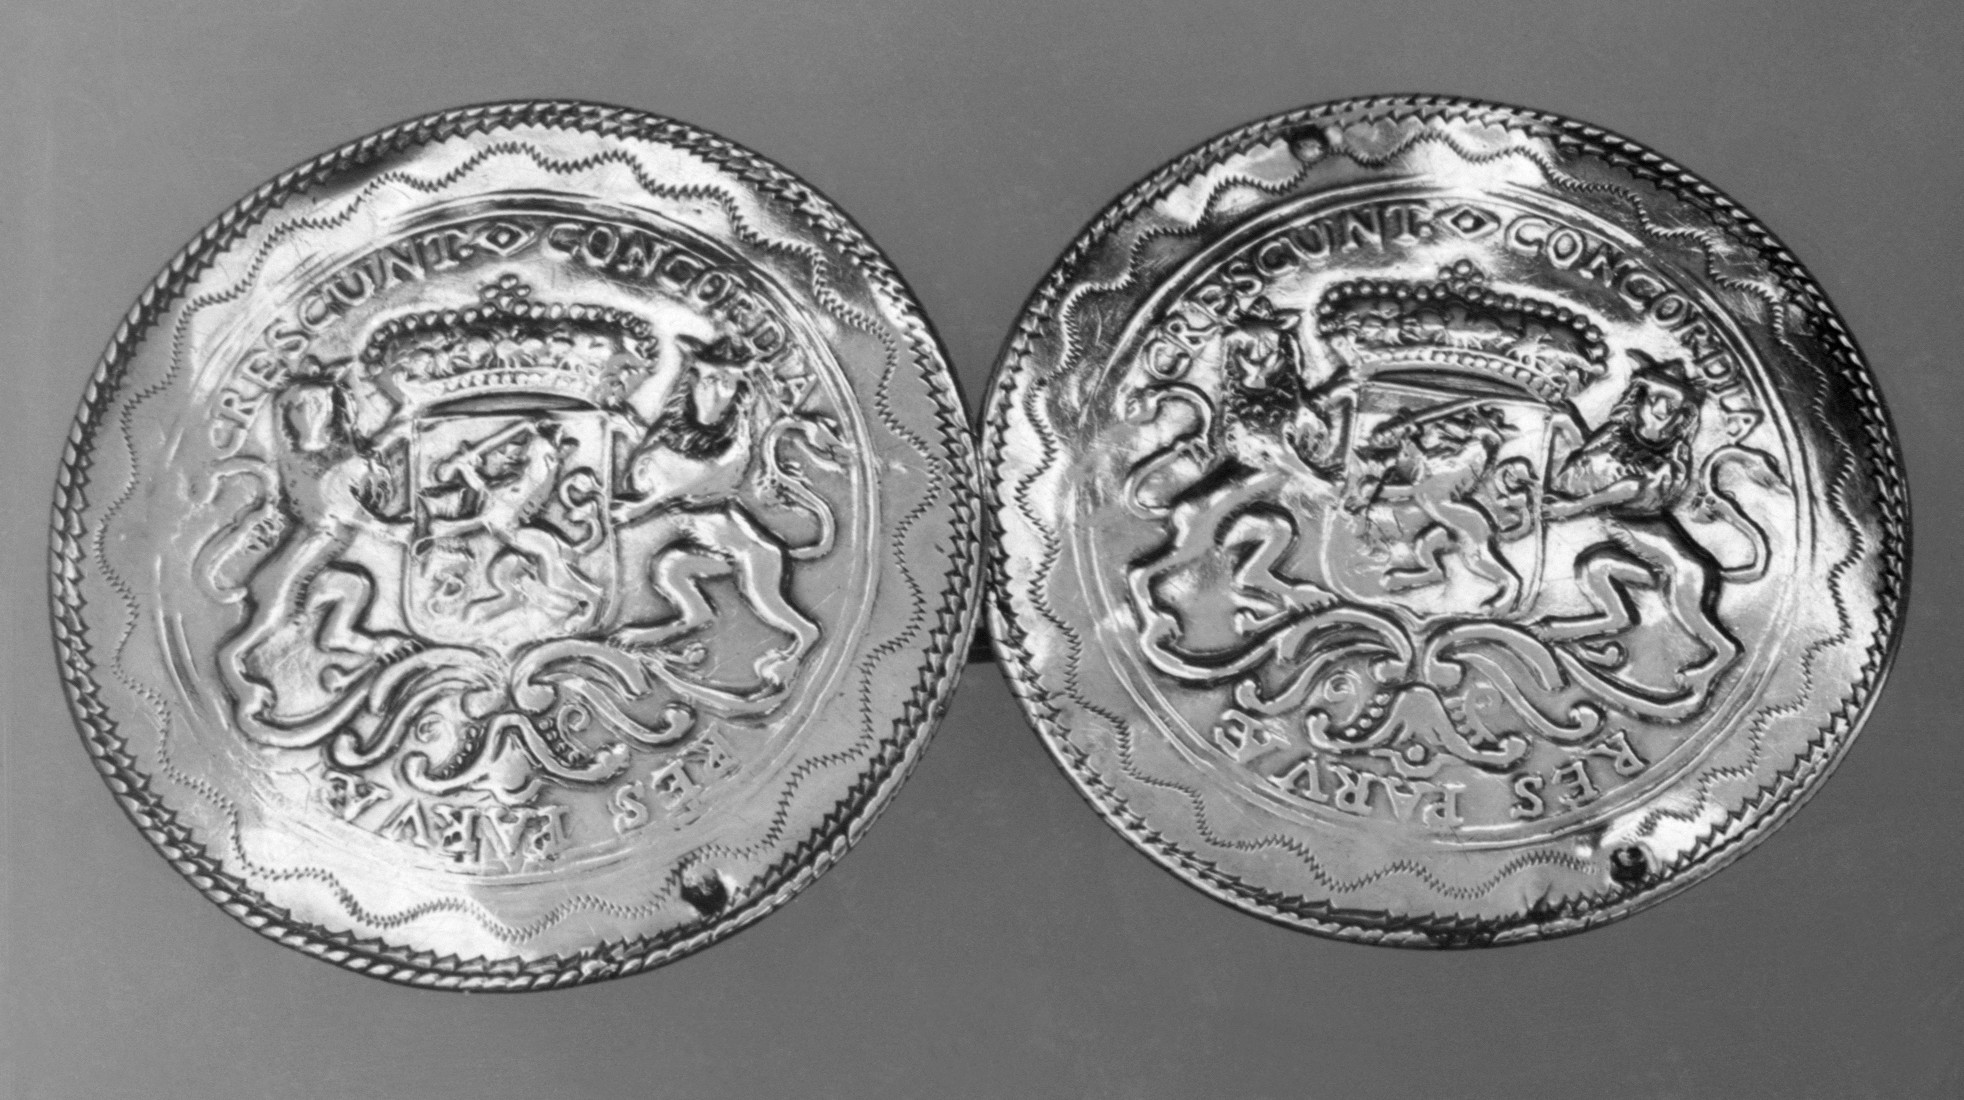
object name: cloak clasp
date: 1801-1900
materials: silver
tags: coat of arms